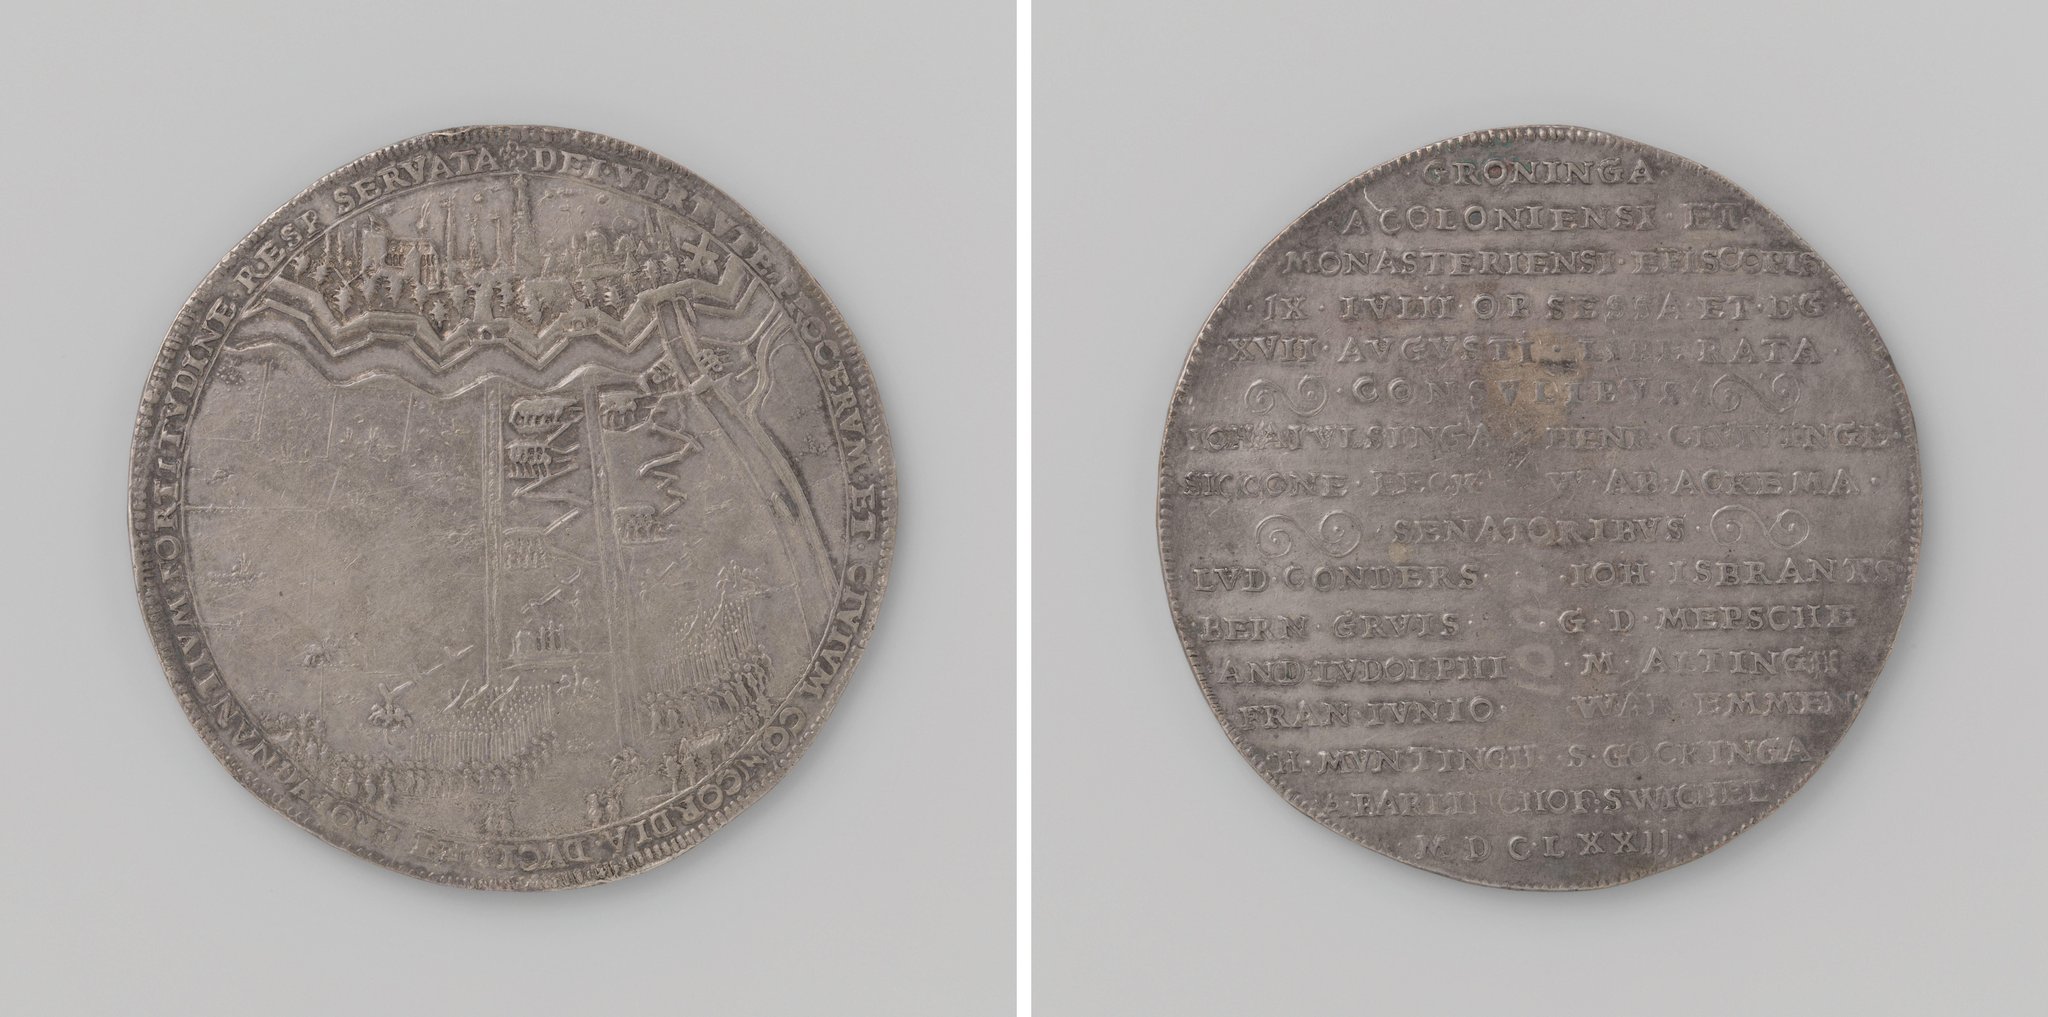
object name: history medal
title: Beleg van Groningen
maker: Anonymous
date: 1672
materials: silver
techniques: striking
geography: netherlands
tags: rampjaar (disaster year)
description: Medals. Several medals were struck to mark the relief of Groningen, and subsequently Coevorden.